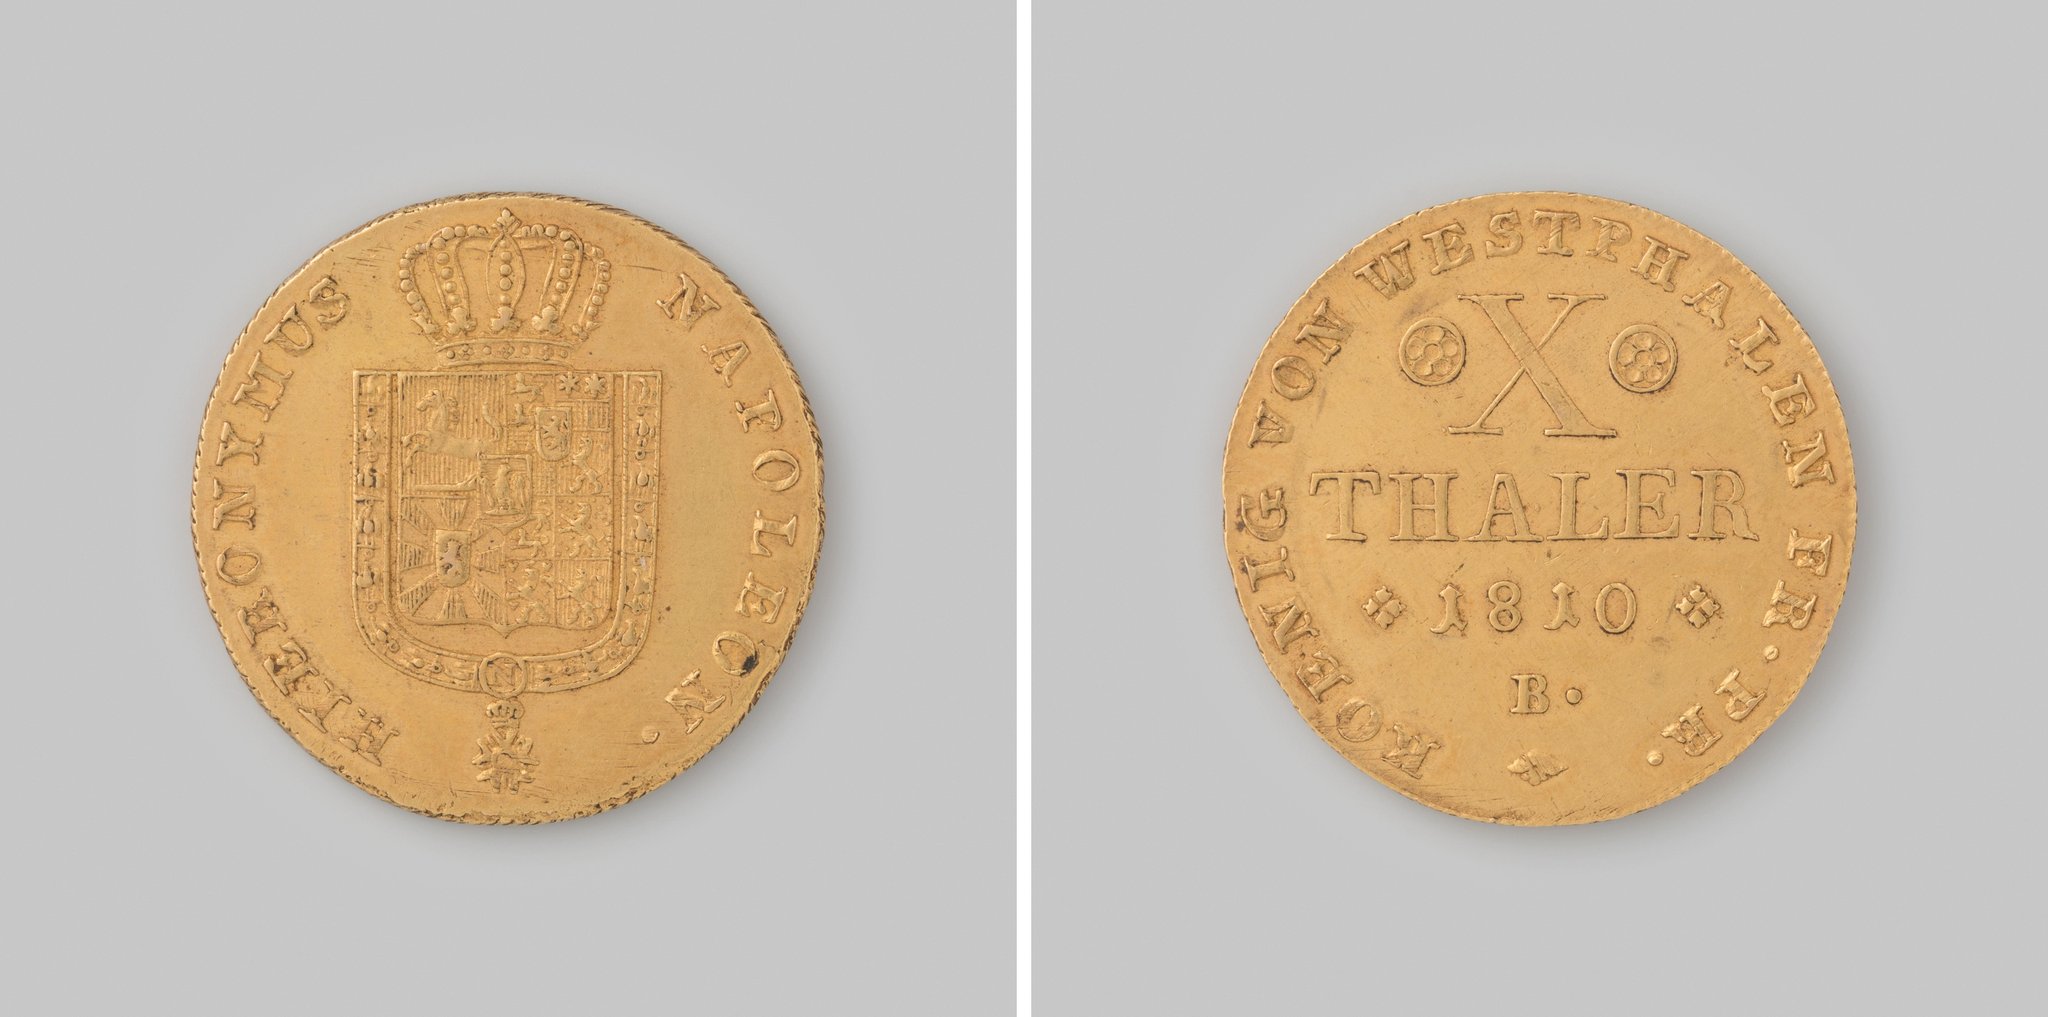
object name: tien taler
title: Tien taler uit het koninkrijk Westfalen van Jérome Napoléon, 1810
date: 1810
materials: gold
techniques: striking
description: Gouden munt. Voorzijde: gekroond samengesteld wapenschild, omhangen met keten van orde, waaaan juweel. Keerzijde: waarde-aanduiding in twee regels, waaronder jaartal. Daaronder letter B [=Brunswick]. Kabelrand.